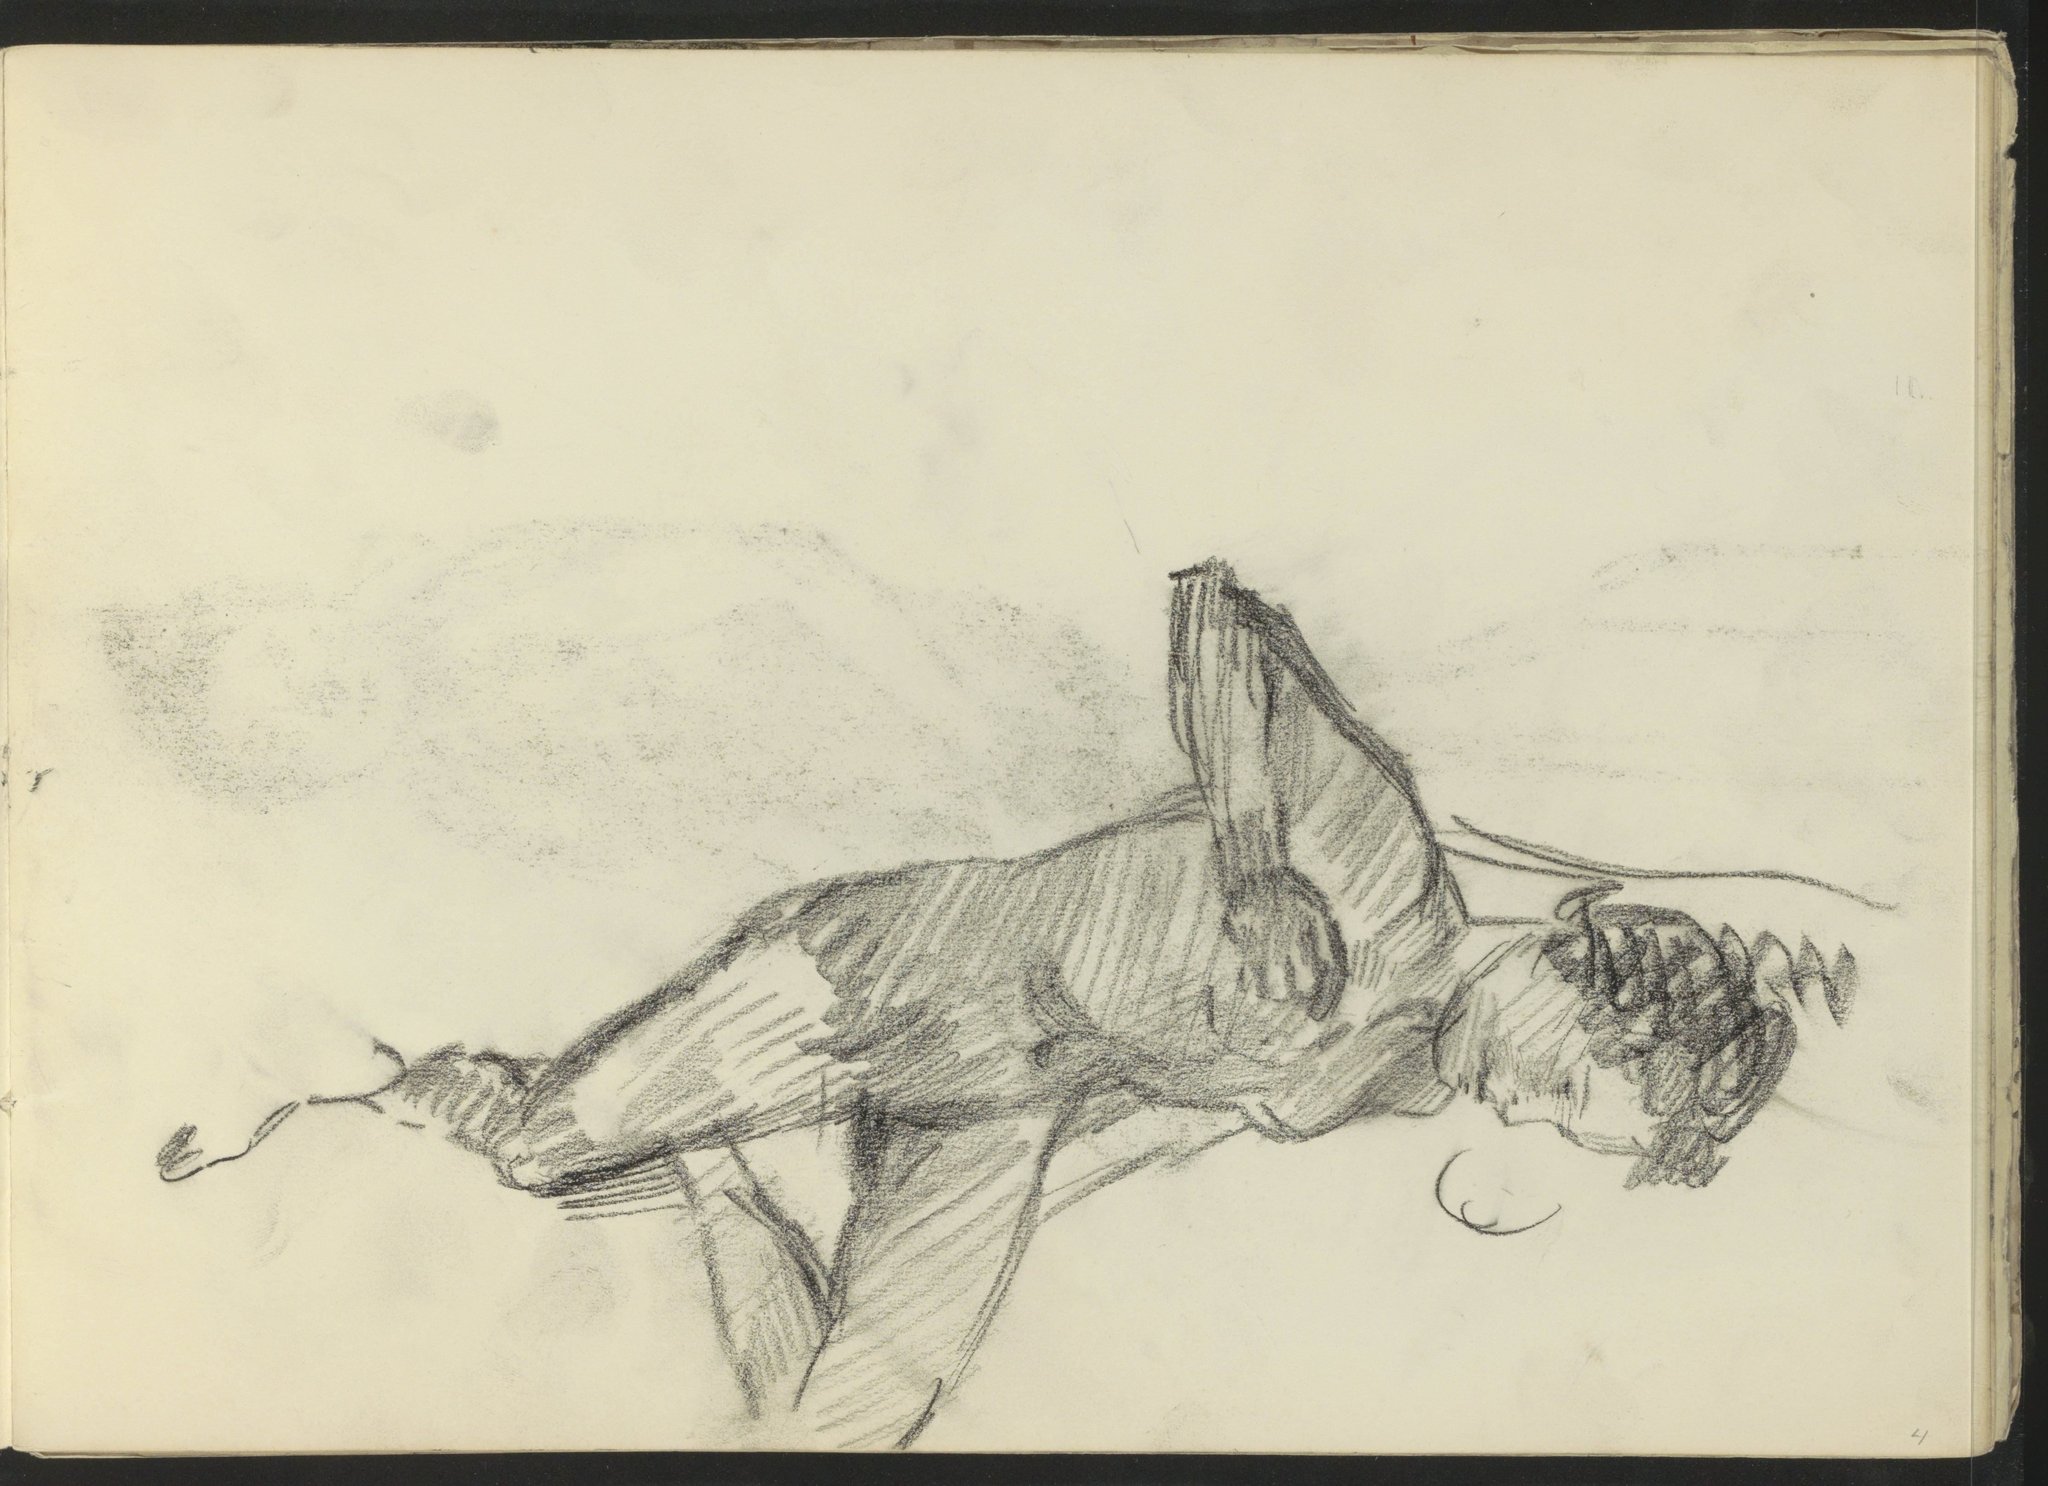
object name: sketchbook leaf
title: Liggend vrouwelijk naakt met opgetrokken linkerbeen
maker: isaac israels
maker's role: draughtsman, painter, print maker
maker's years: 1865-1934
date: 1875-1934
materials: chalk, paper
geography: the hague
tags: the (nude) human figure; 'corpo humano' (ripa) - aa - female human figure (+ lying)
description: Blad 4 recto uit schetsboek XII met 19 bladen.